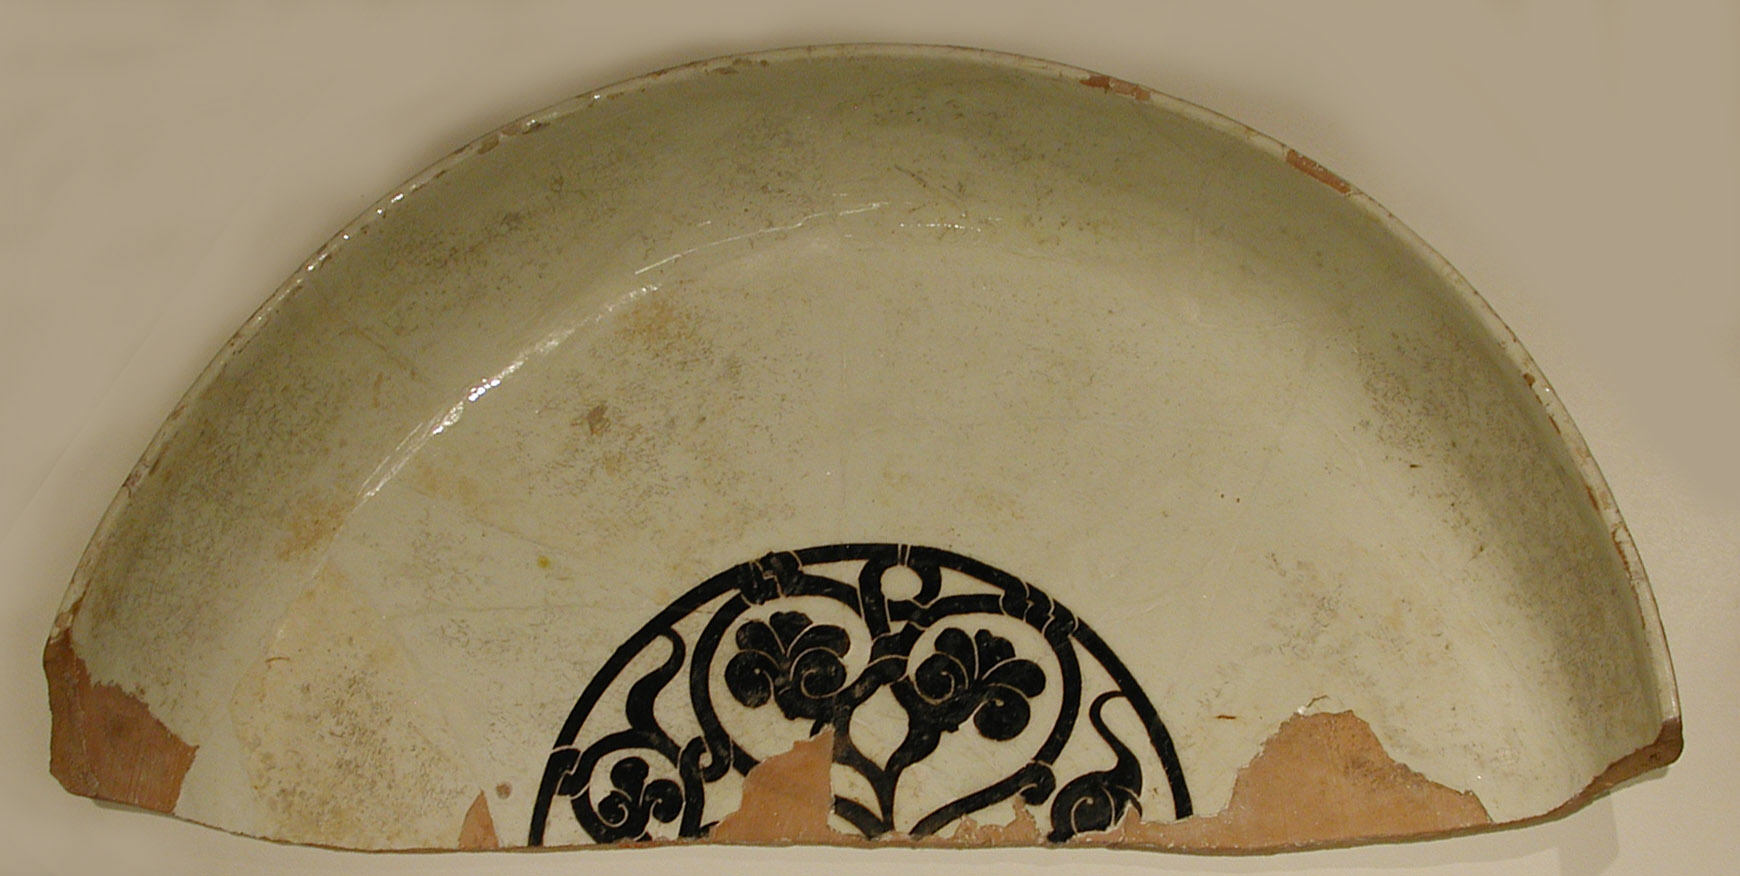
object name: fragment of a dish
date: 901-1000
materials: earthenware, glaze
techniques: incising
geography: uzbekistan